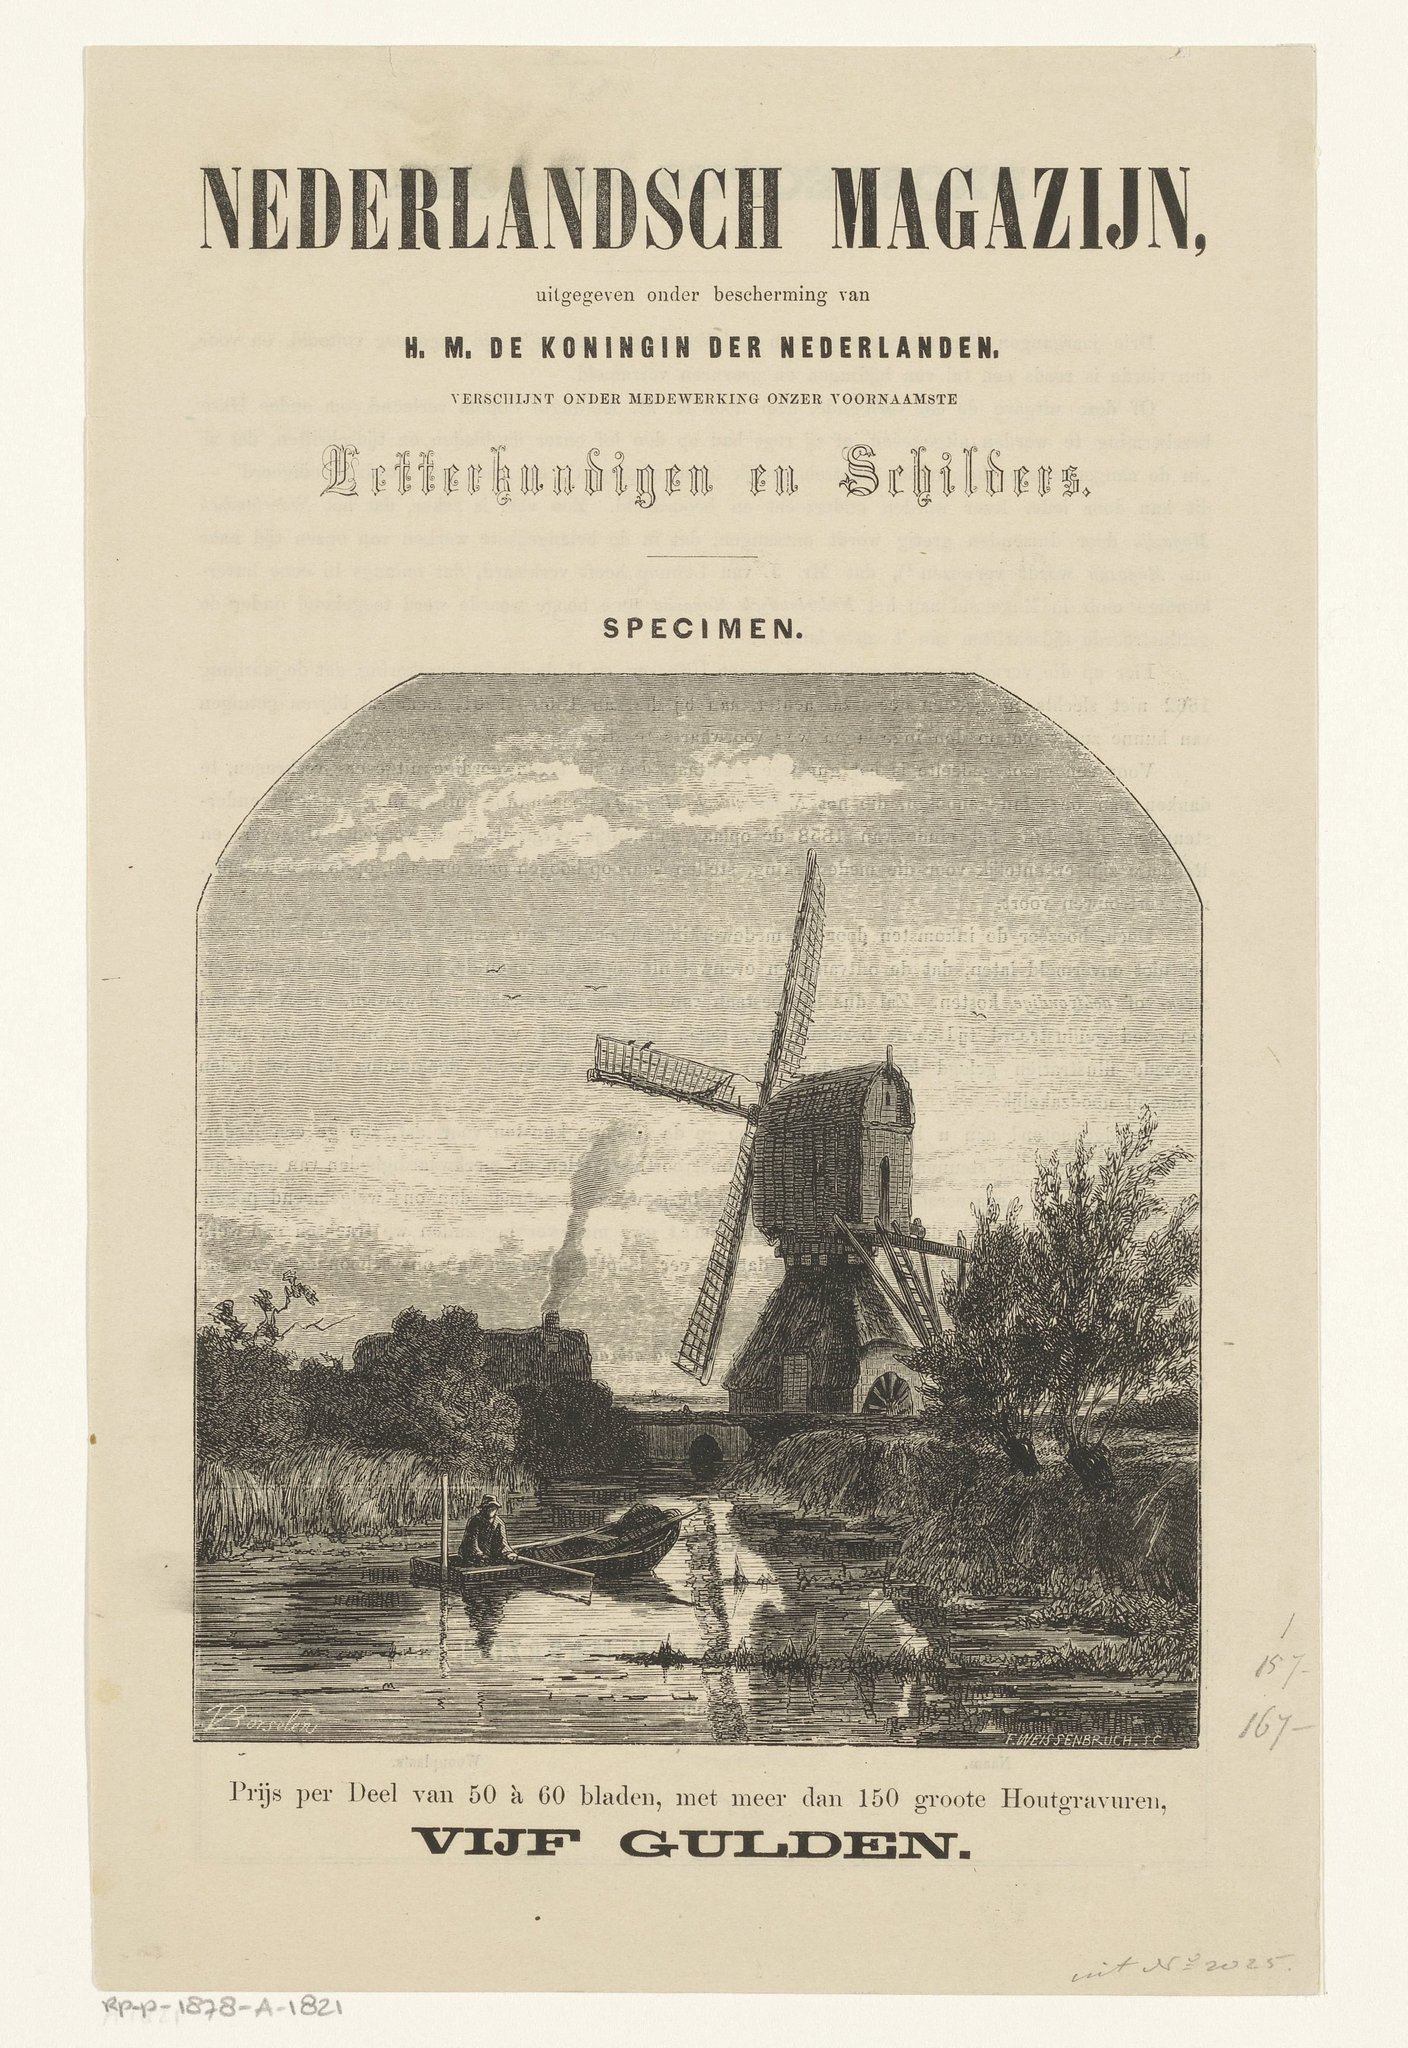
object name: book illustration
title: Polderlandschap met een molen en een visser in een boot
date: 1861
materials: paper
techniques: letterpress printing, engraving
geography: the hague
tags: windmill in landscape (+ city(-scape) with figures, staffage), fisherman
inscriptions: collector's mark: Lugt 2228